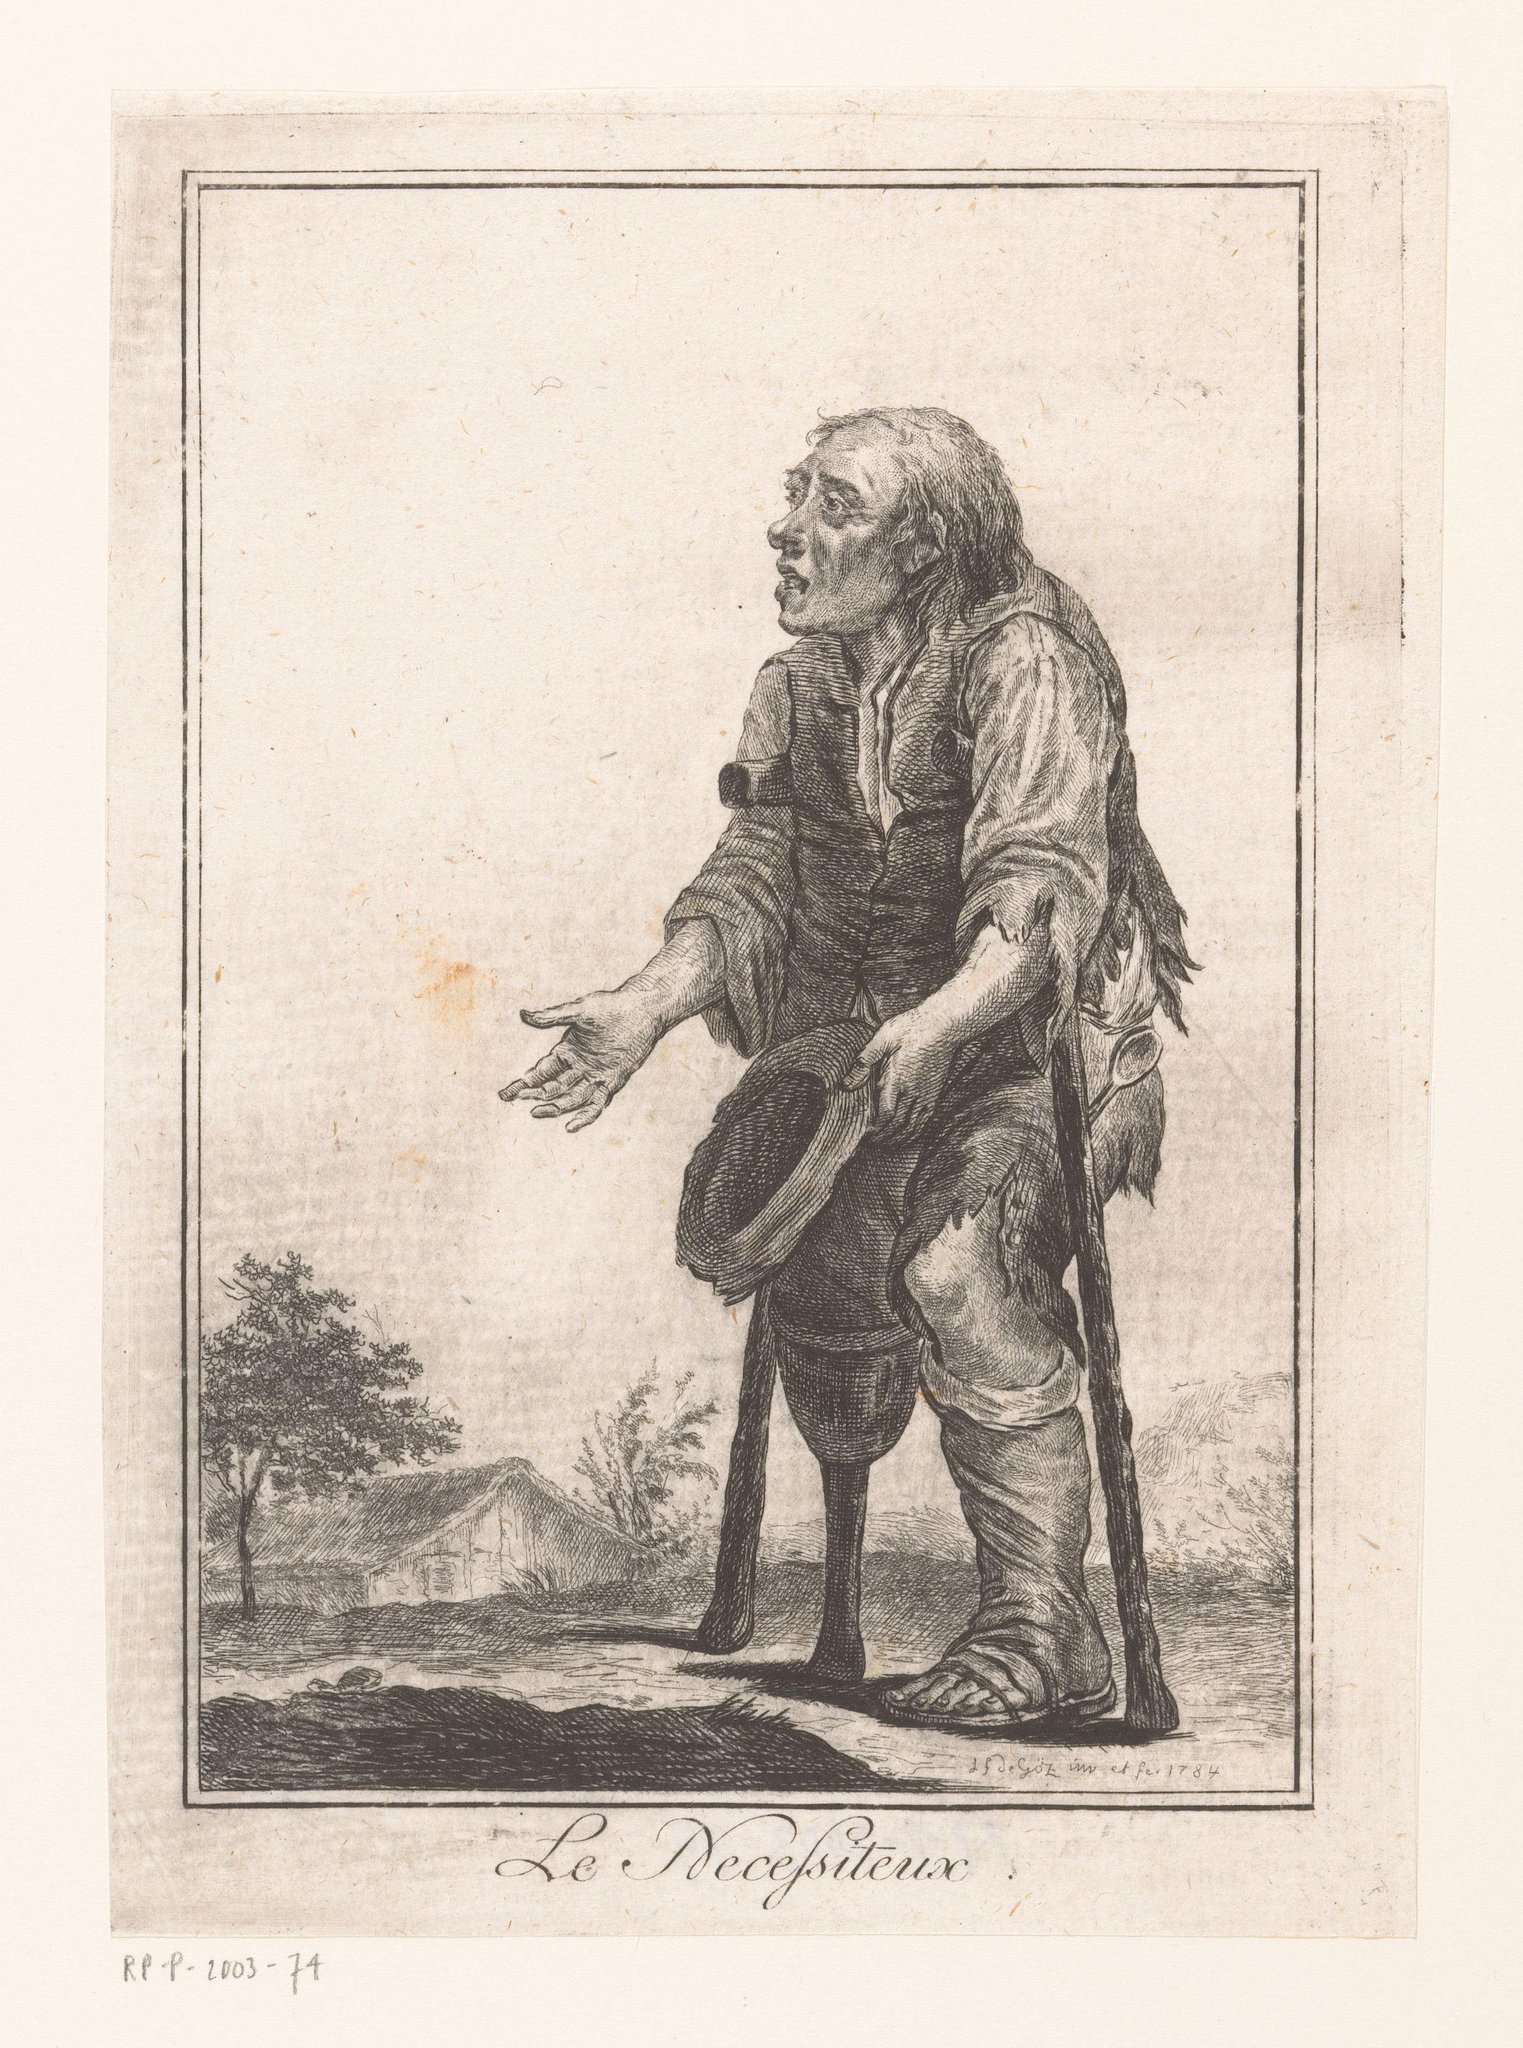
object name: print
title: Bedelaar met krukken en een houten been in een landschap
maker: joseph franz freiherr von goez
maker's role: print maker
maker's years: 1754-1815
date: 1784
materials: paper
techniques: engraving, etching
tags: landscapes, crutches, wooden leg, beggar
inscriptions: collector's mark: Lugt 2760, collector's mark: Lugt 2228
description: Prent uit een serie getiteld: "Exercises d'imagination de differens Caractères et Formes humaines inventés peints et dessinés par J. F. de Goez Suite 1", bestaande uit honderd platen met verschillende figuren met elk een eigen titel. Plaat 1 t/m 84 zijn van de hand van Brichet naar ontwerp van Von Goez en plaat 85 t/m 100 zijn door Von Goez zelf geëtst.